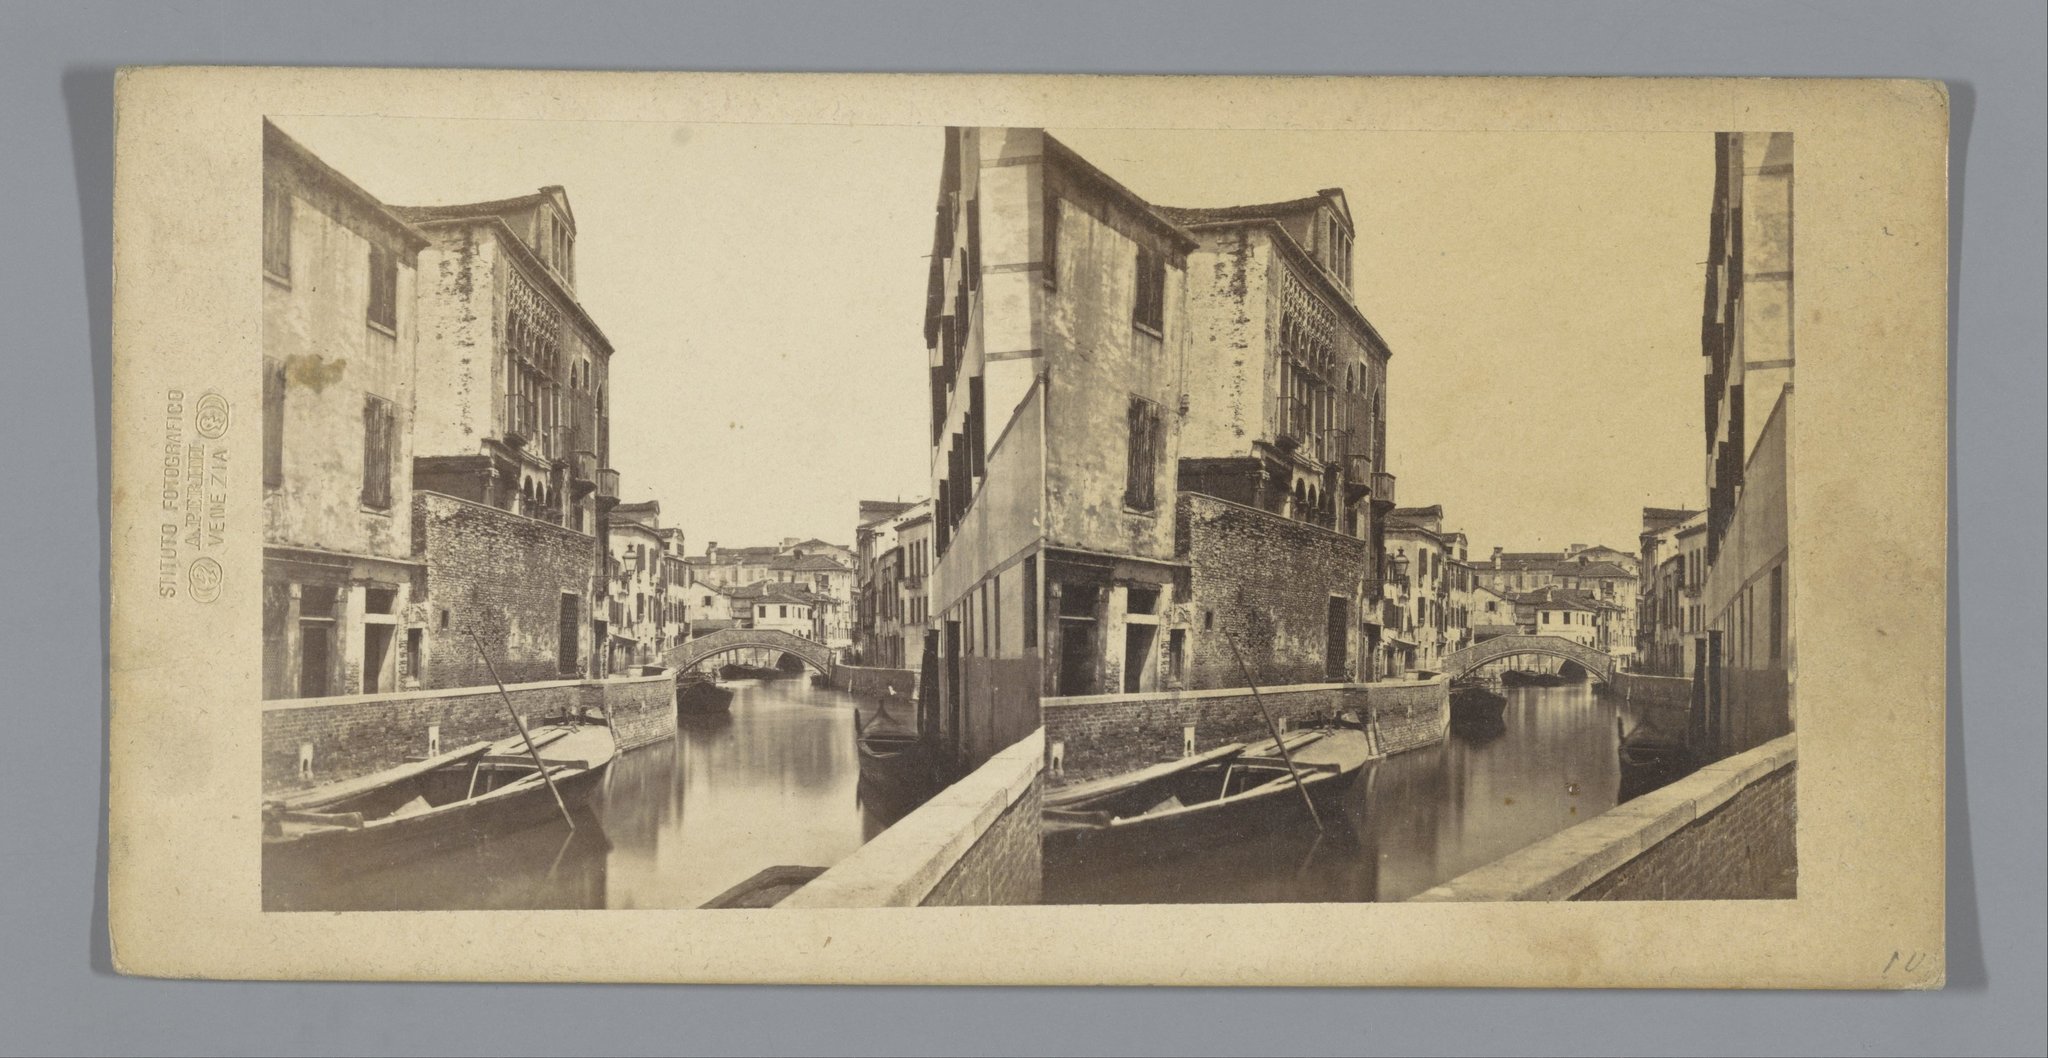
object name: stereograph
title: Gezicht op Rio dei Carmini te Venetië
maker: antonio perini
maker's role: fotograaf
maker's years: 1830-1879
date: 1850-1879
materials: cardboard, photographic support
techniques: albumen print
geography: venice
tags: canal, façade (of house or building), venice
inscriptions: name: ‘STITUTO FOTOGRAFICO A.PERINI VENEZIA’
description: Gezicht op Rio dei Carmini, gezien vanaf de Chiesa dell 'Angelo Raffaele richting Fondamenta Briati.